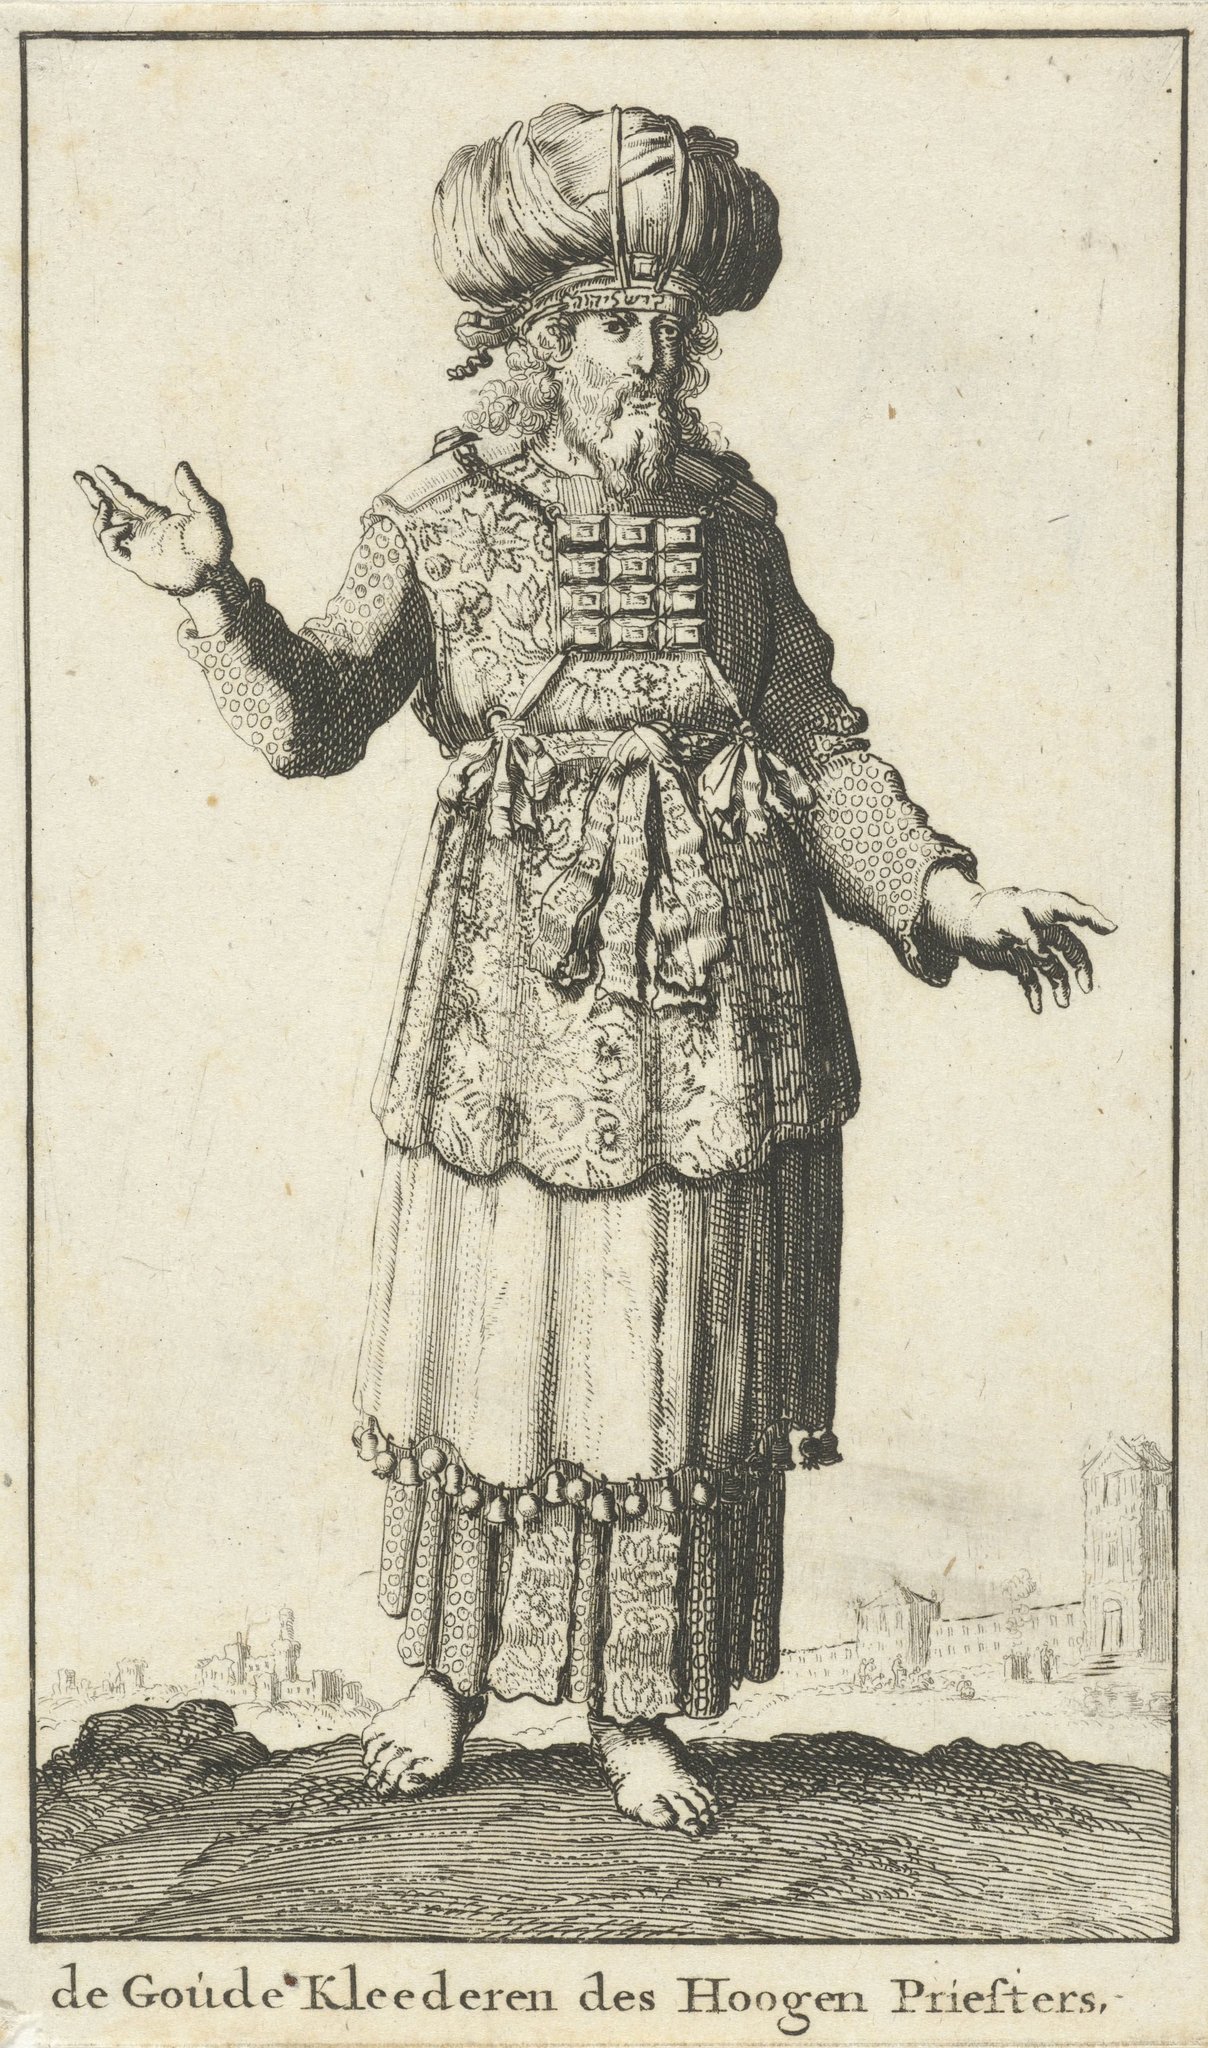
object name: book illustration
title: De Goude Kleederen des Hoogen Priesters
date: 1682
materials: paper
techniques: etching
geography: amsterdam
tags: high priest ~ hierarchy of priests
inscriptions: collector's mark: Lugt 2228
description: Illustratie opgenomen in: Cunaeus, Petrus. De republyk der Hebreen, of gemeenebest der joden, 3 delen. Amsterdam: Wilhelmus Goeree, 1682, dl. 1, p. 166.